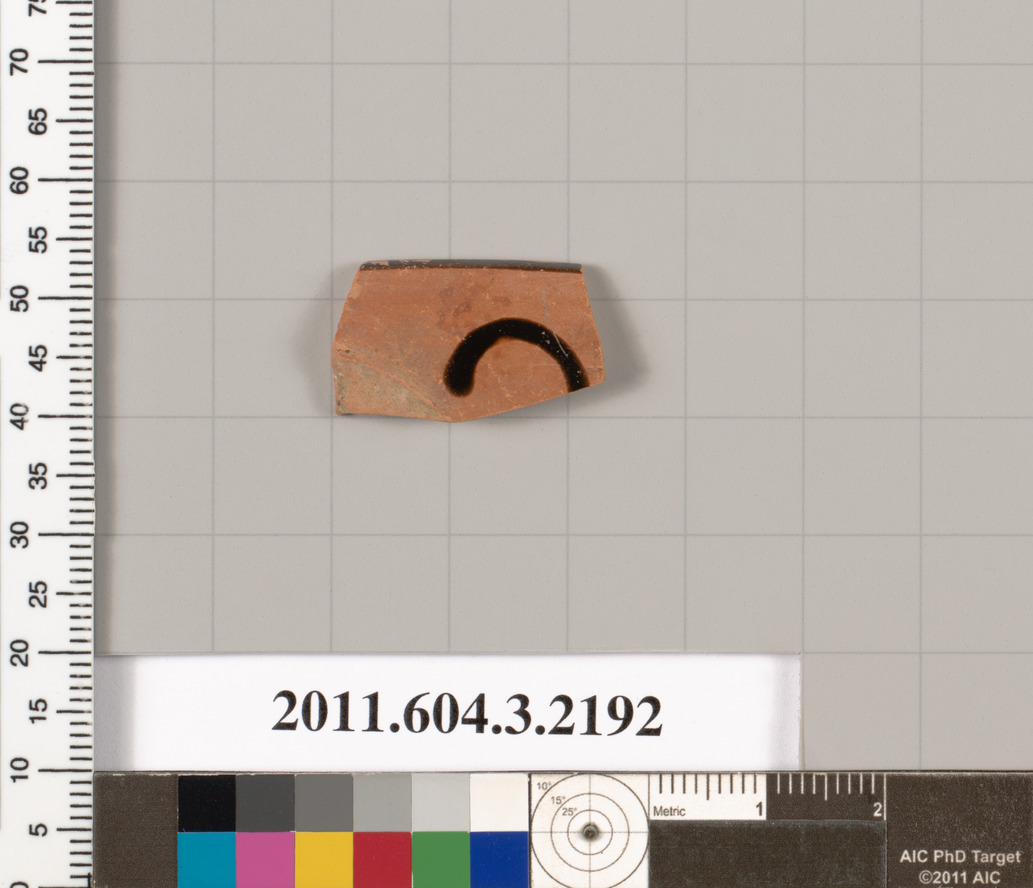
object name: kylix fragment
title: Terracotta rim fragment of a kylix (drinking cup)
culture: greek, attic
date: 534-501 BCE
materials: terracotta